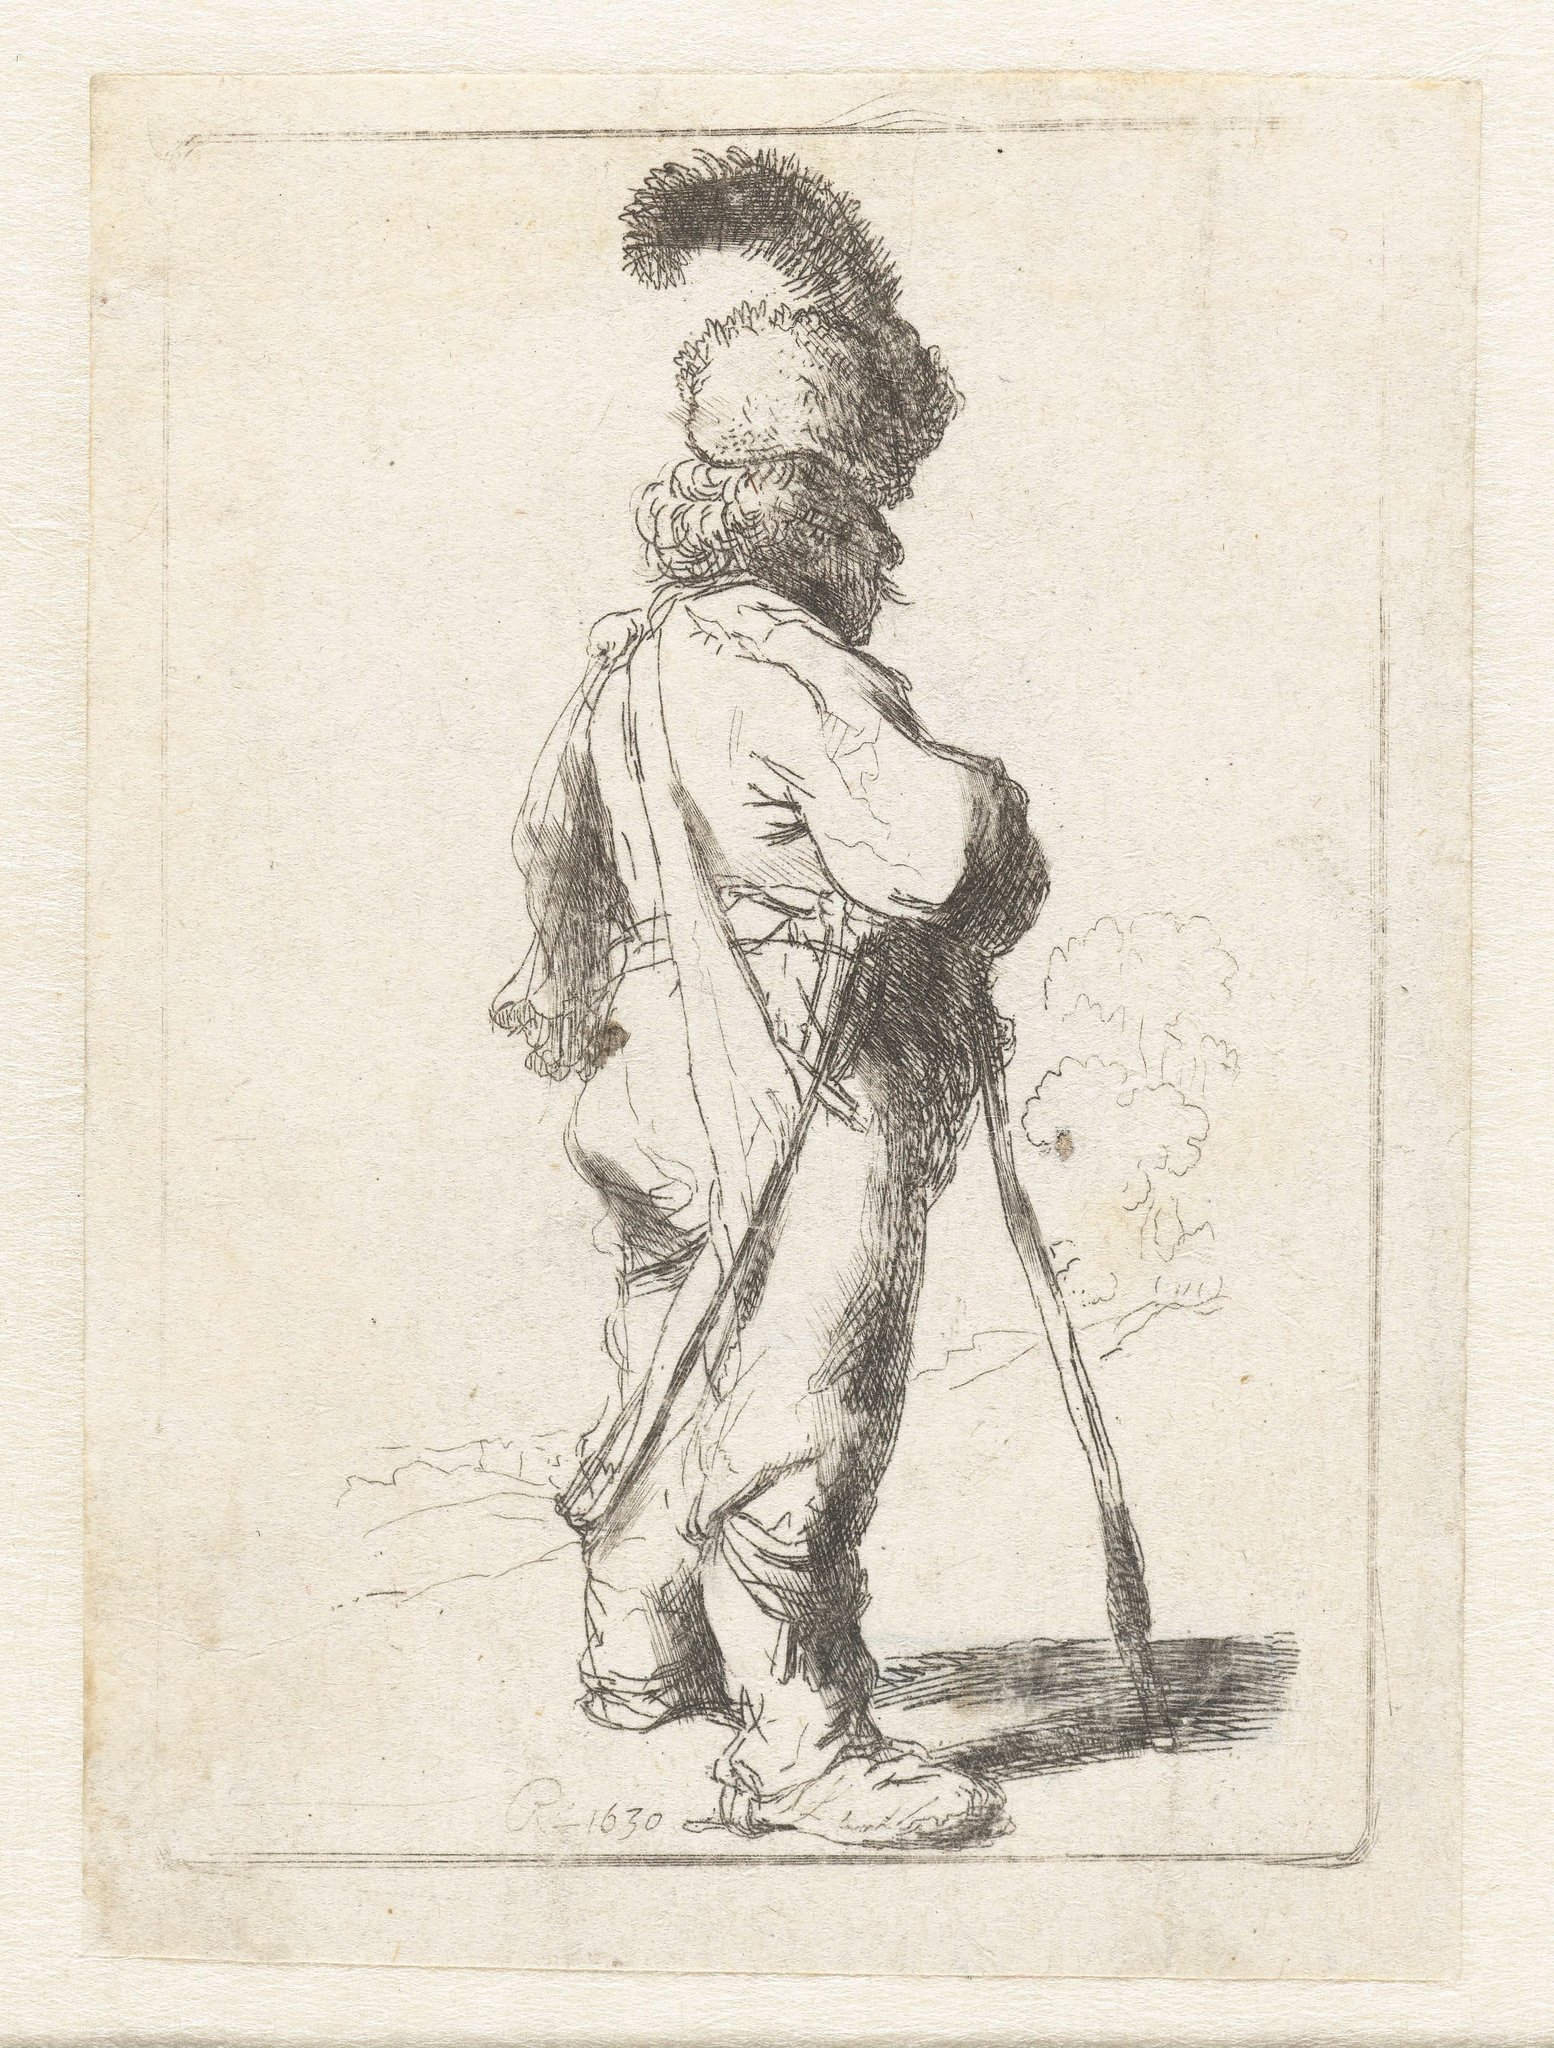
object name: print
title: Polander leaning on a stick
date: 1630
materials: paper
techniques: etching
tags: adult man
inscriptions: collector's mark: Lugt 4071, collector's mark: Lugt 2760, collector's mark: Lugt 2228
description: Spiegelbeeldige kopie naar de gelijknamige prent van Rembrandt.